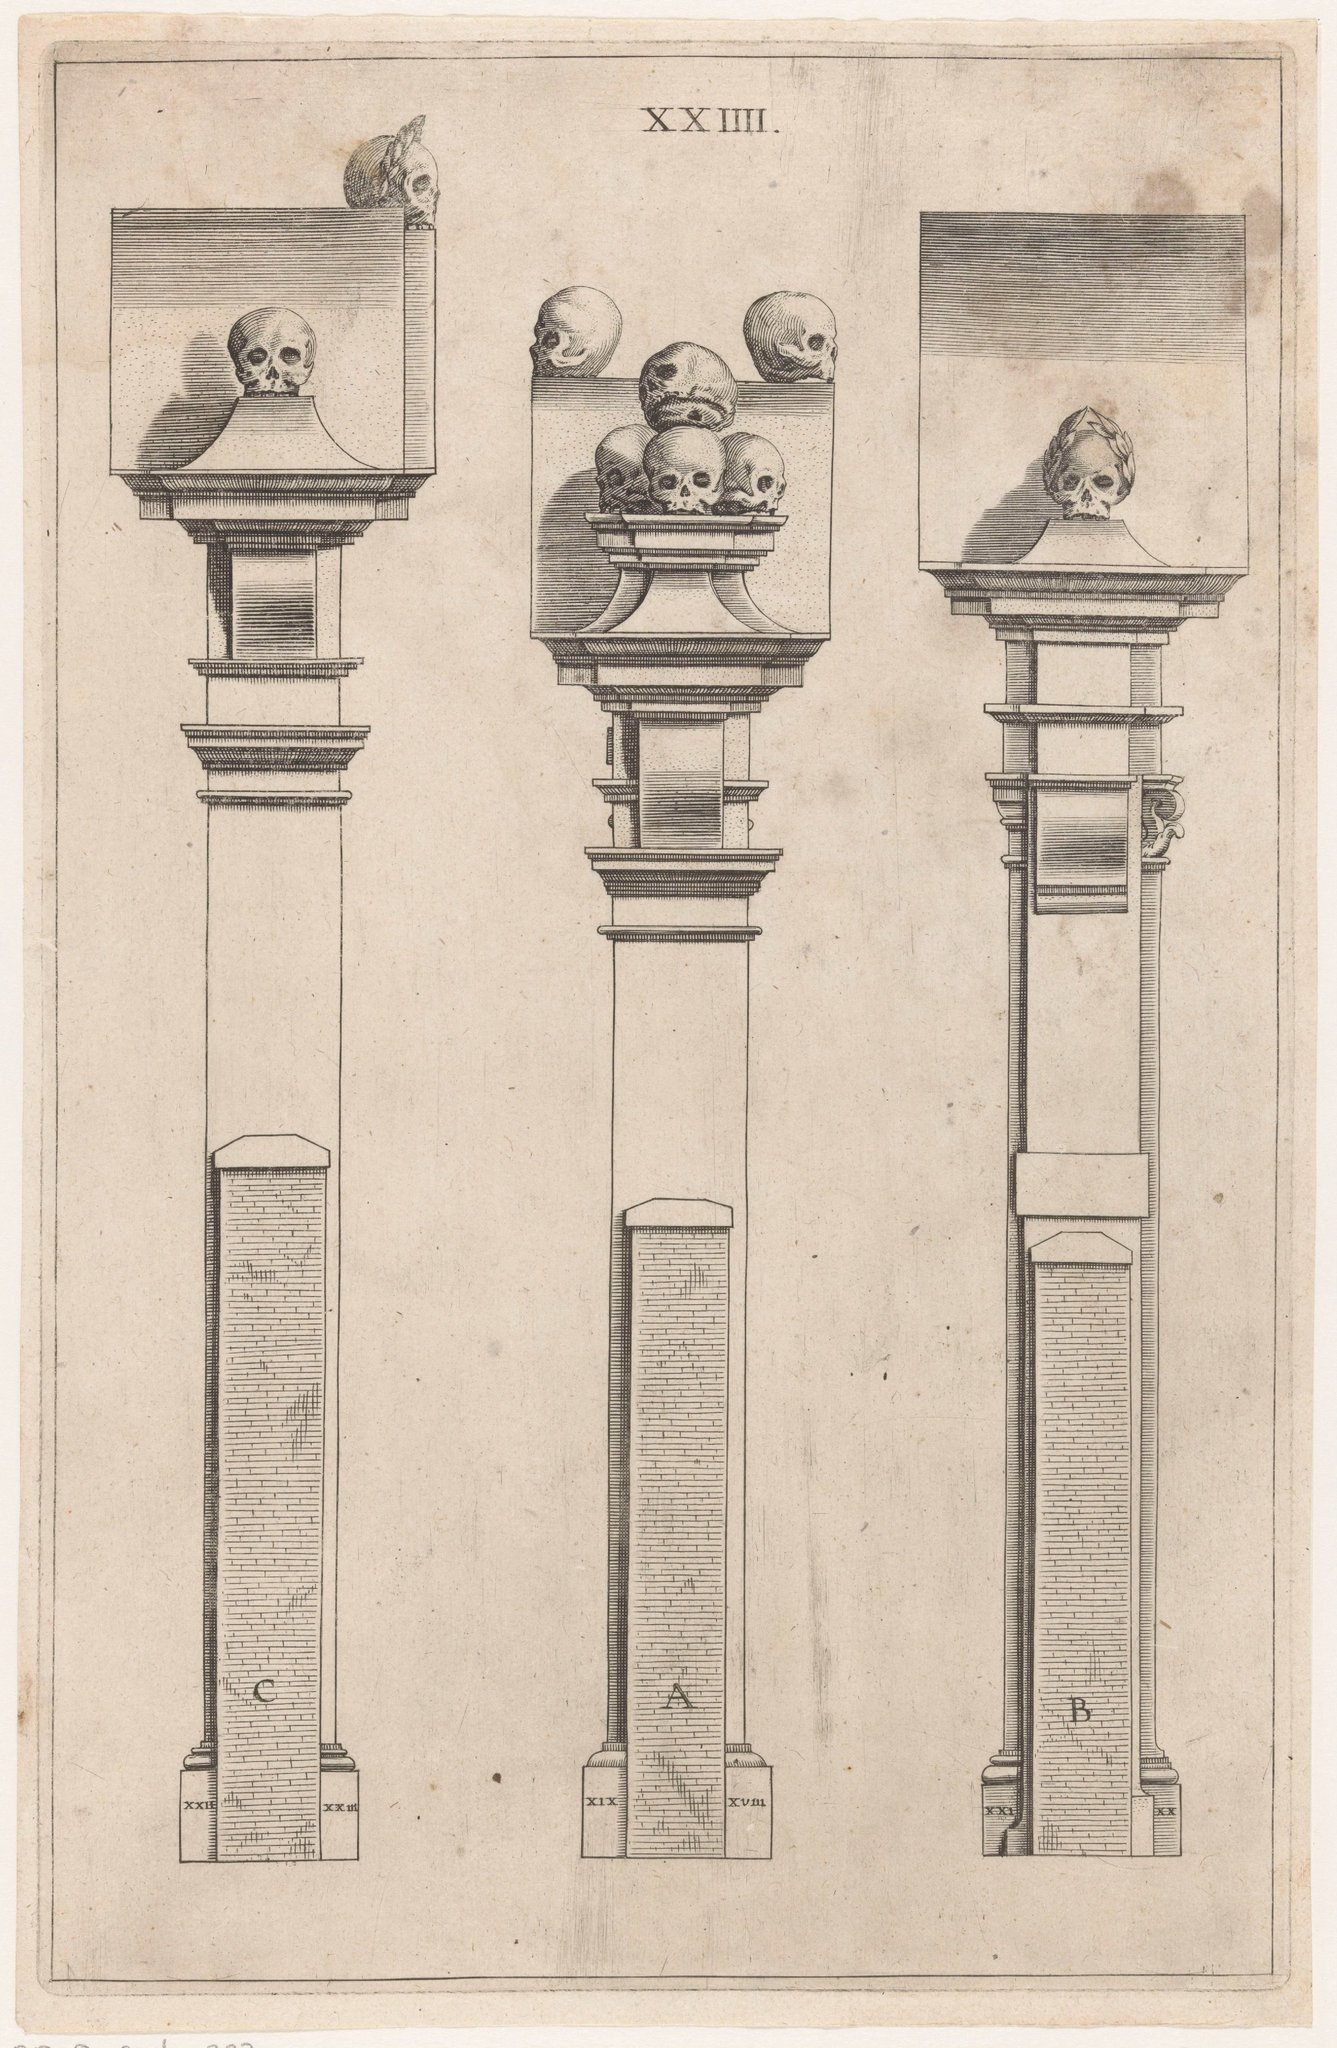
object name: print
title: Zijaanzichten van poorten naar begraafplaats de Westerkerk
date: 1631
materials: paper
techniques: engraving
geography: amsterdam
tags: churchyard, cemetery, exterior ~ architectural design or model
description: Prent uit: Keyser, Hendrick de. Architectura moderna ofte bouwinge van onsen tyt (...) alle gedaen by (...) Amsterdam: Danckerts, Cornelis, 1631.